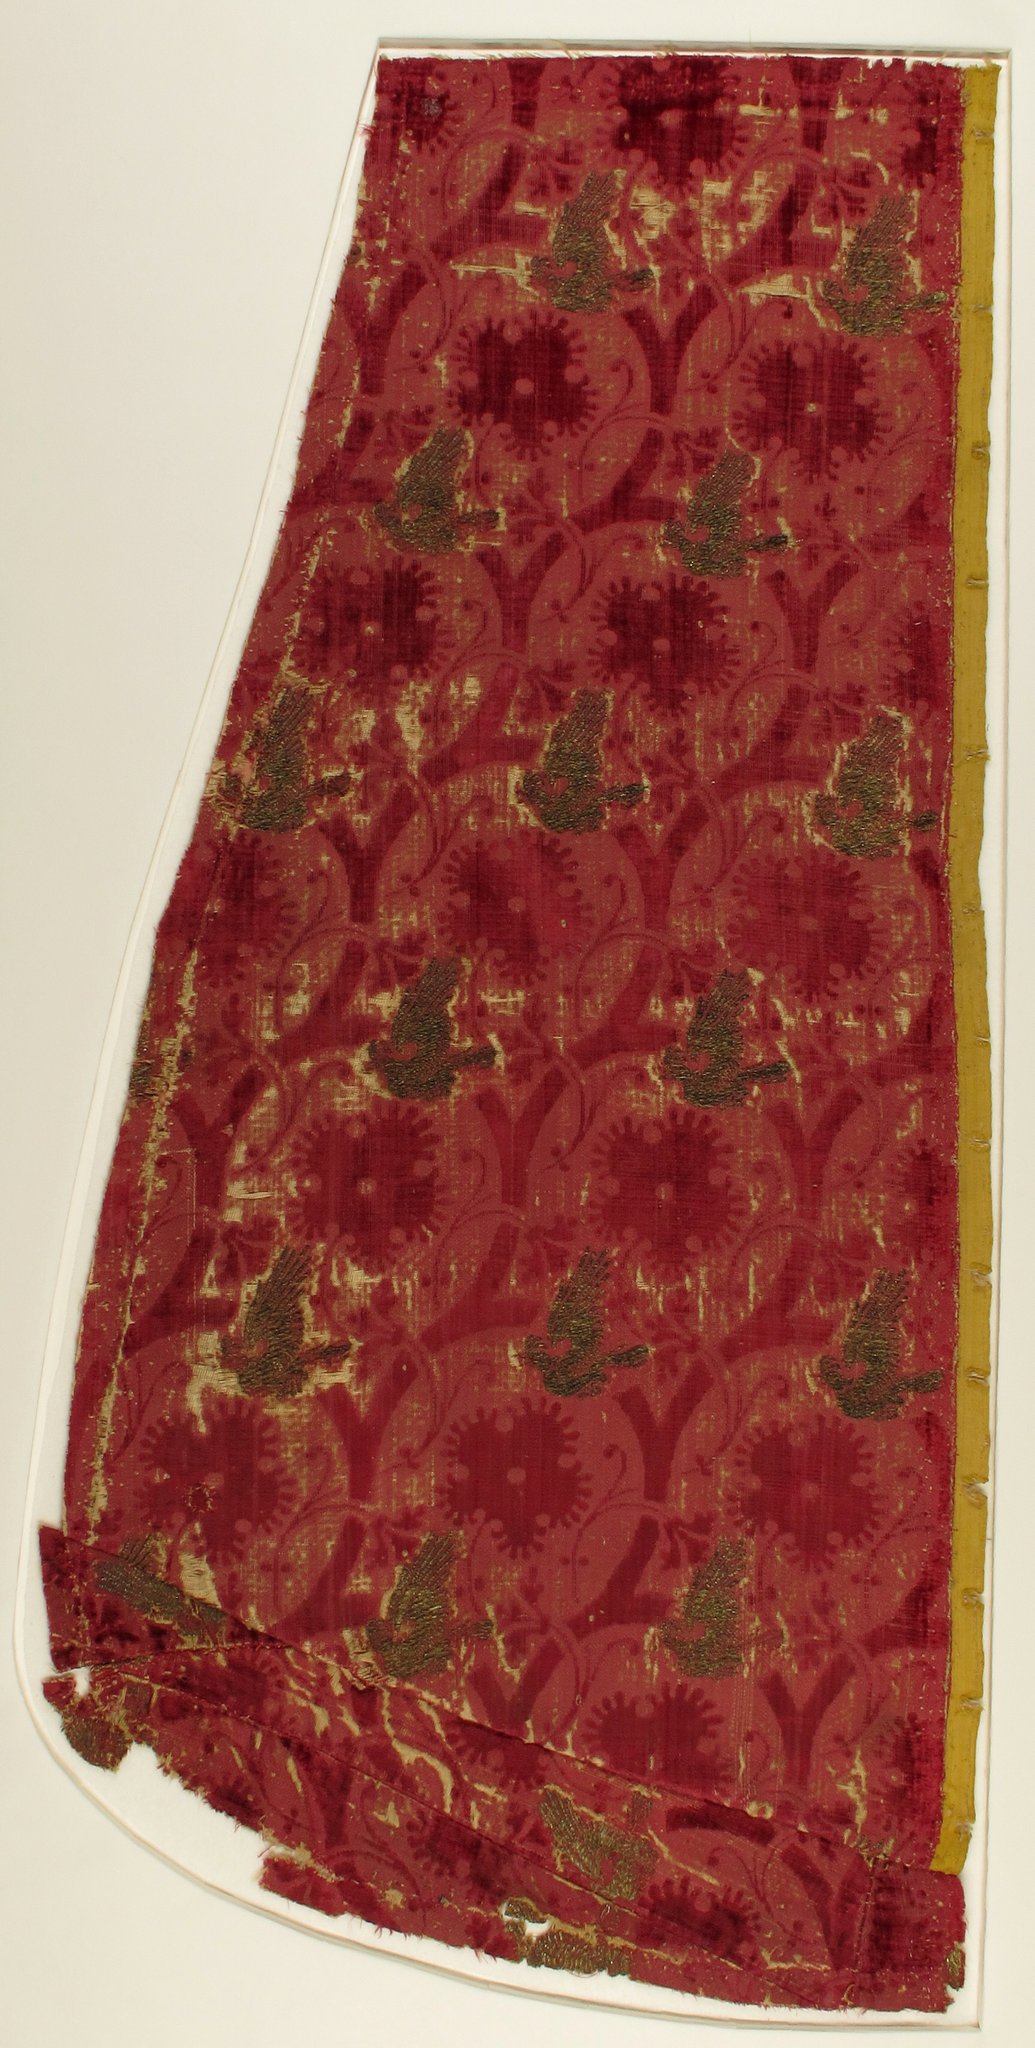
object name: textile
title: Textile with Brocade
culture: italian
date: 1425-1450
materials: thread, velvet